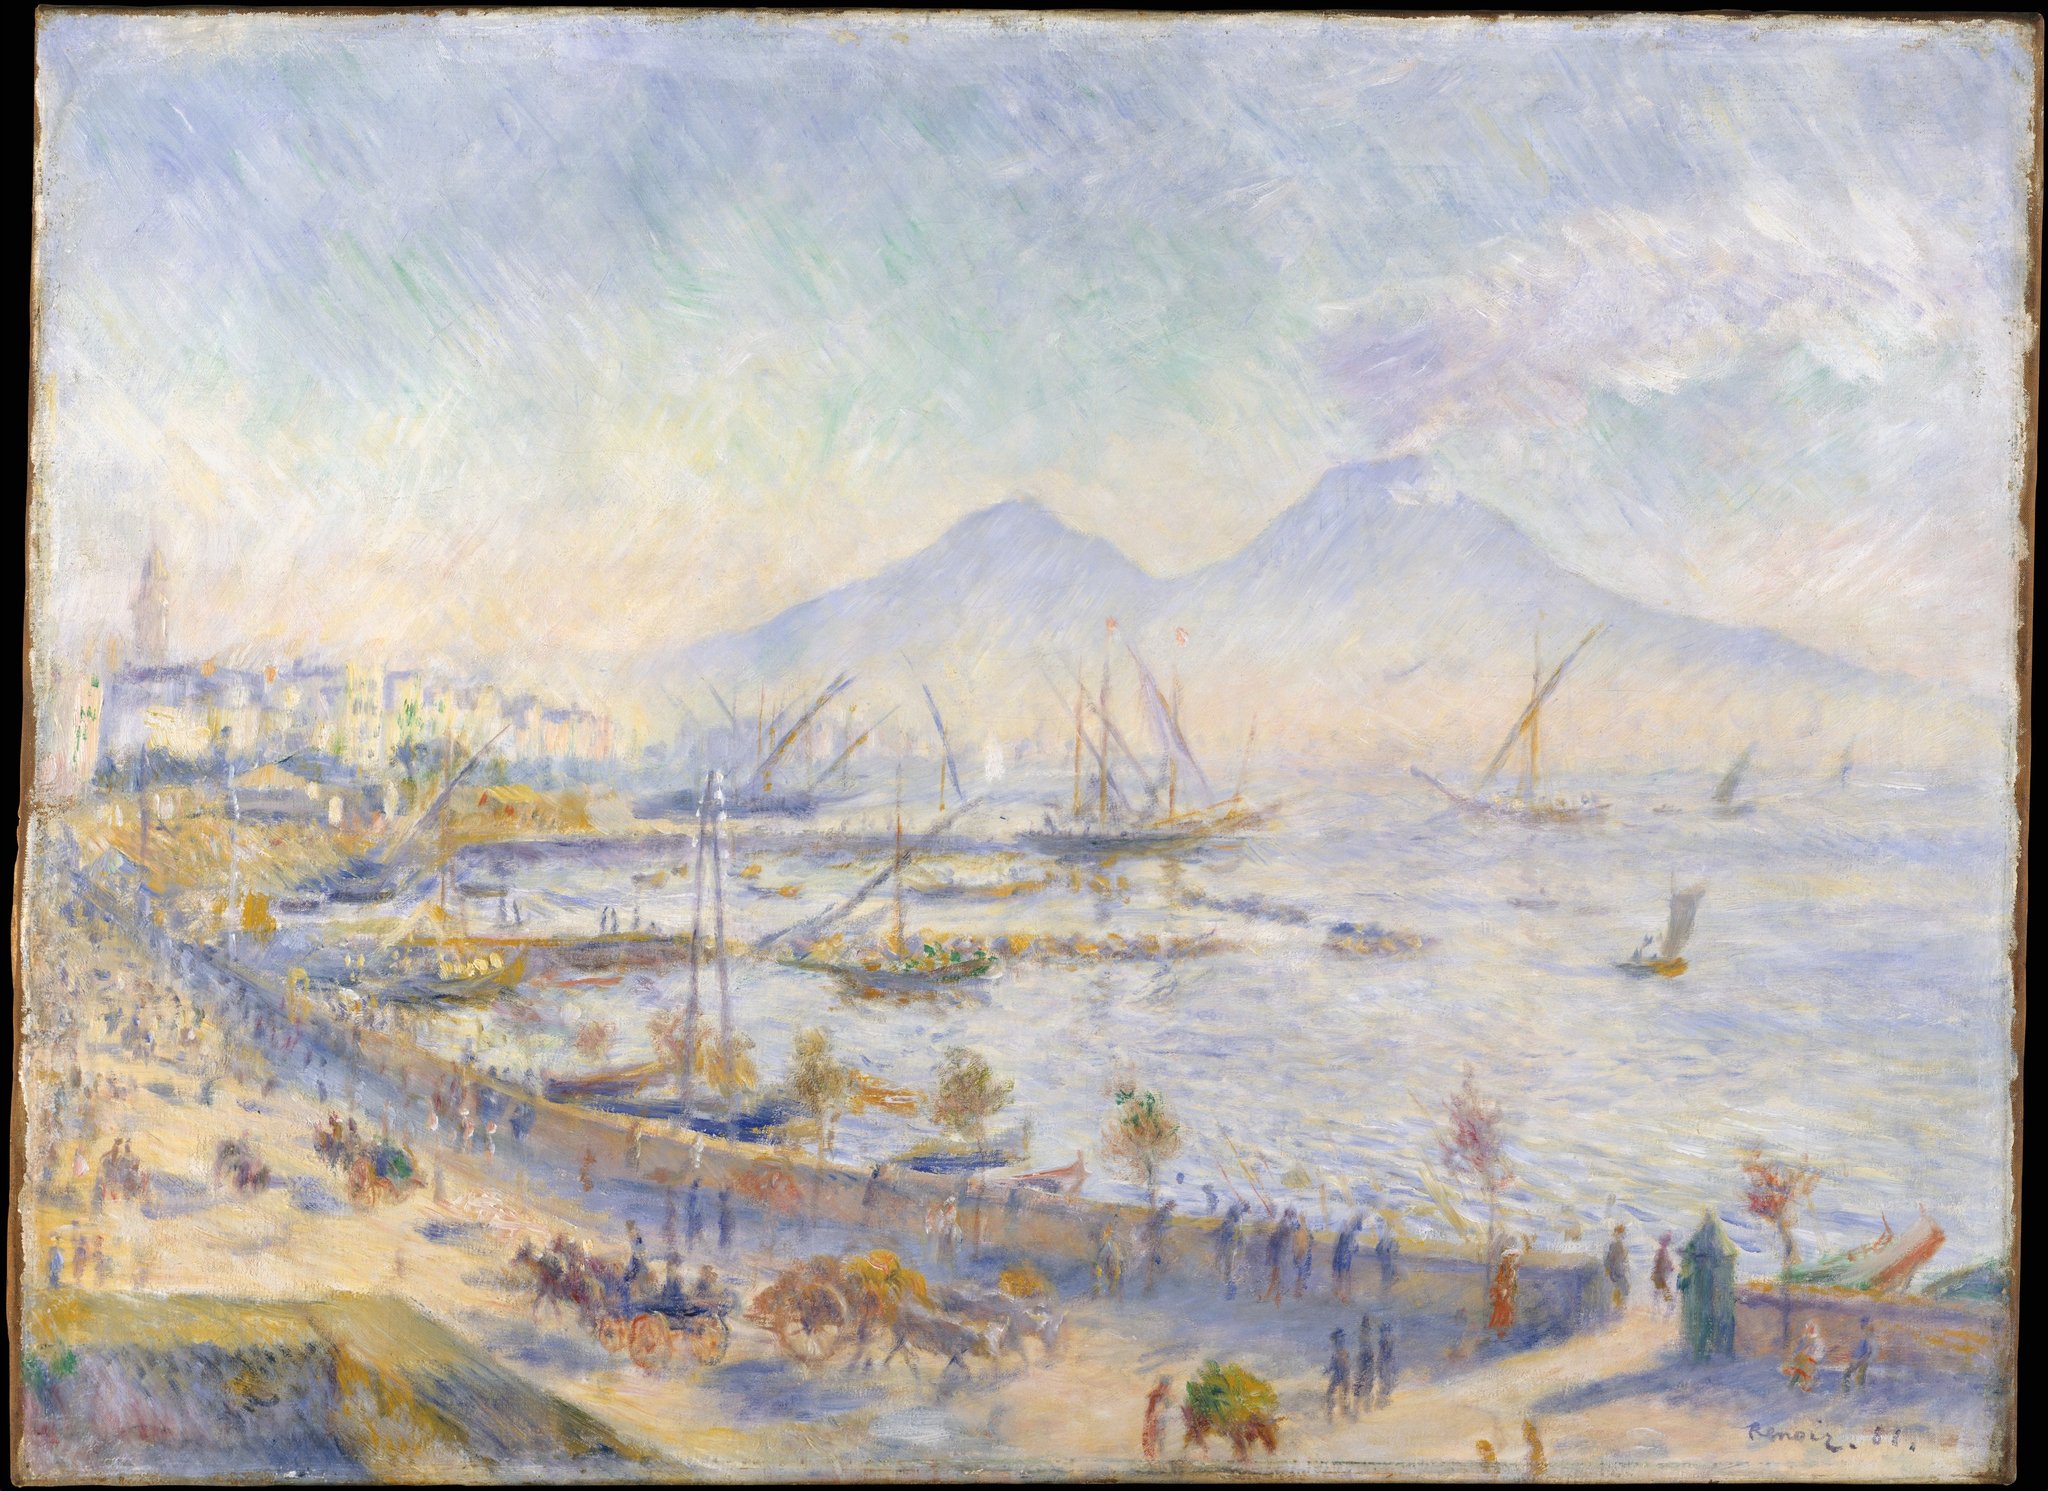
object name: painting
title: The Bay of Naples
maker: pierre auguste renoir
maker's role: artist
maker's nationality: french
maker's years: 1841-1919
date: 1881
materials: canvas, oil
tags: seas,mountains,boats